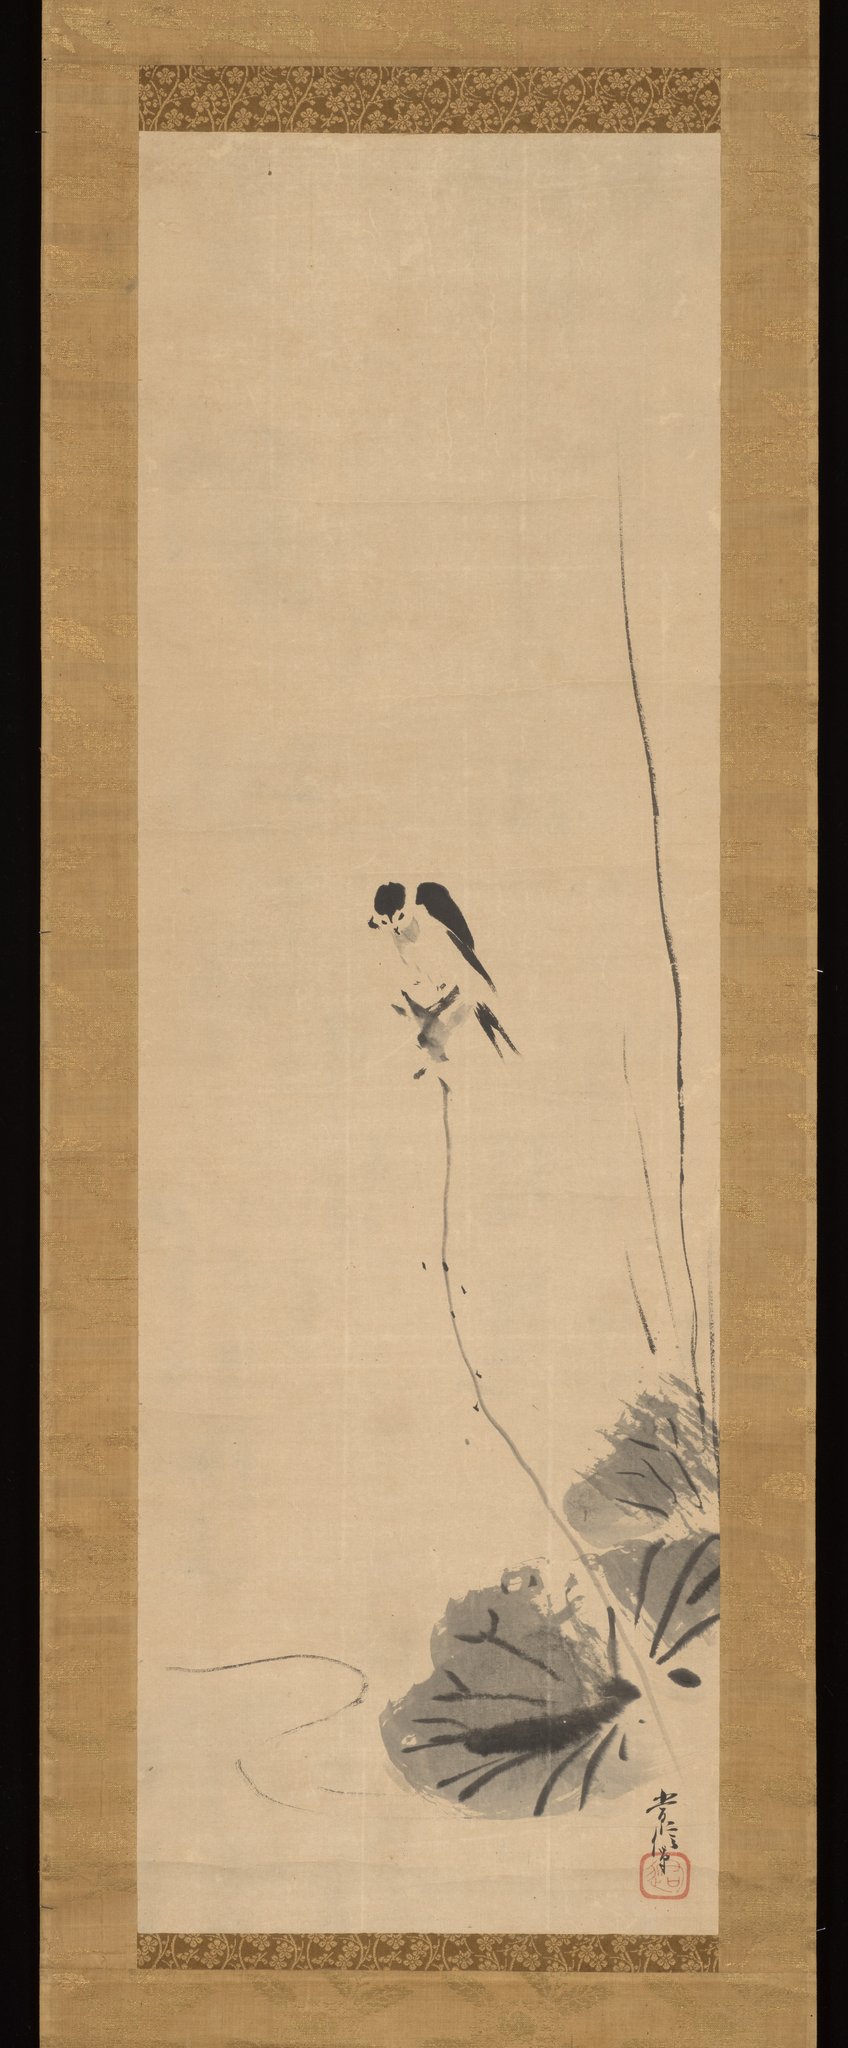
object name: hanging scroll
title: Swallow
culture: japanese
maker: kano tsunenobu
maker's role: artist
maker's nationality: japanese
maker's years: 1636-1713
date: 1636-1713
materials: ink, paper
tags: birds